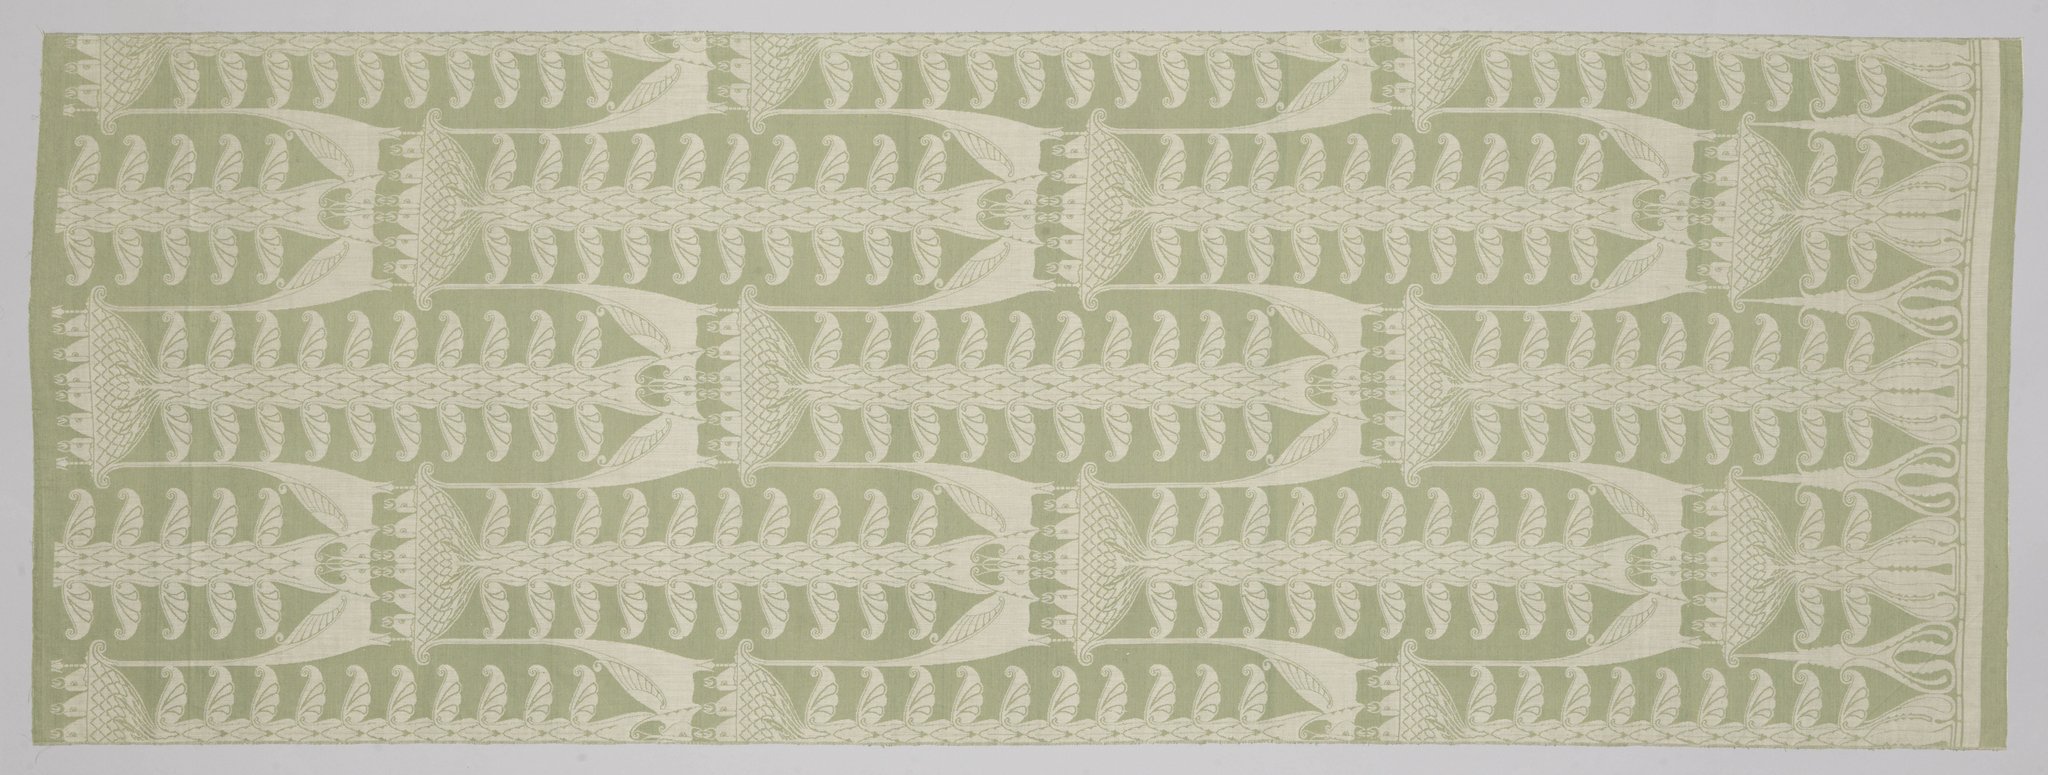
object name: upholstered wall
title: Wandbespanning van paarse damast met dessin van vogelnesten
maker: chris lebeau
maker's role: draughtsman, print maker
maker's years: 1878-1945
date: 1911-1915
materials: linen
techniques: damask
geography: eindhoven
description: Wandbespanning van paarse damast met dessin van vogelnesten.